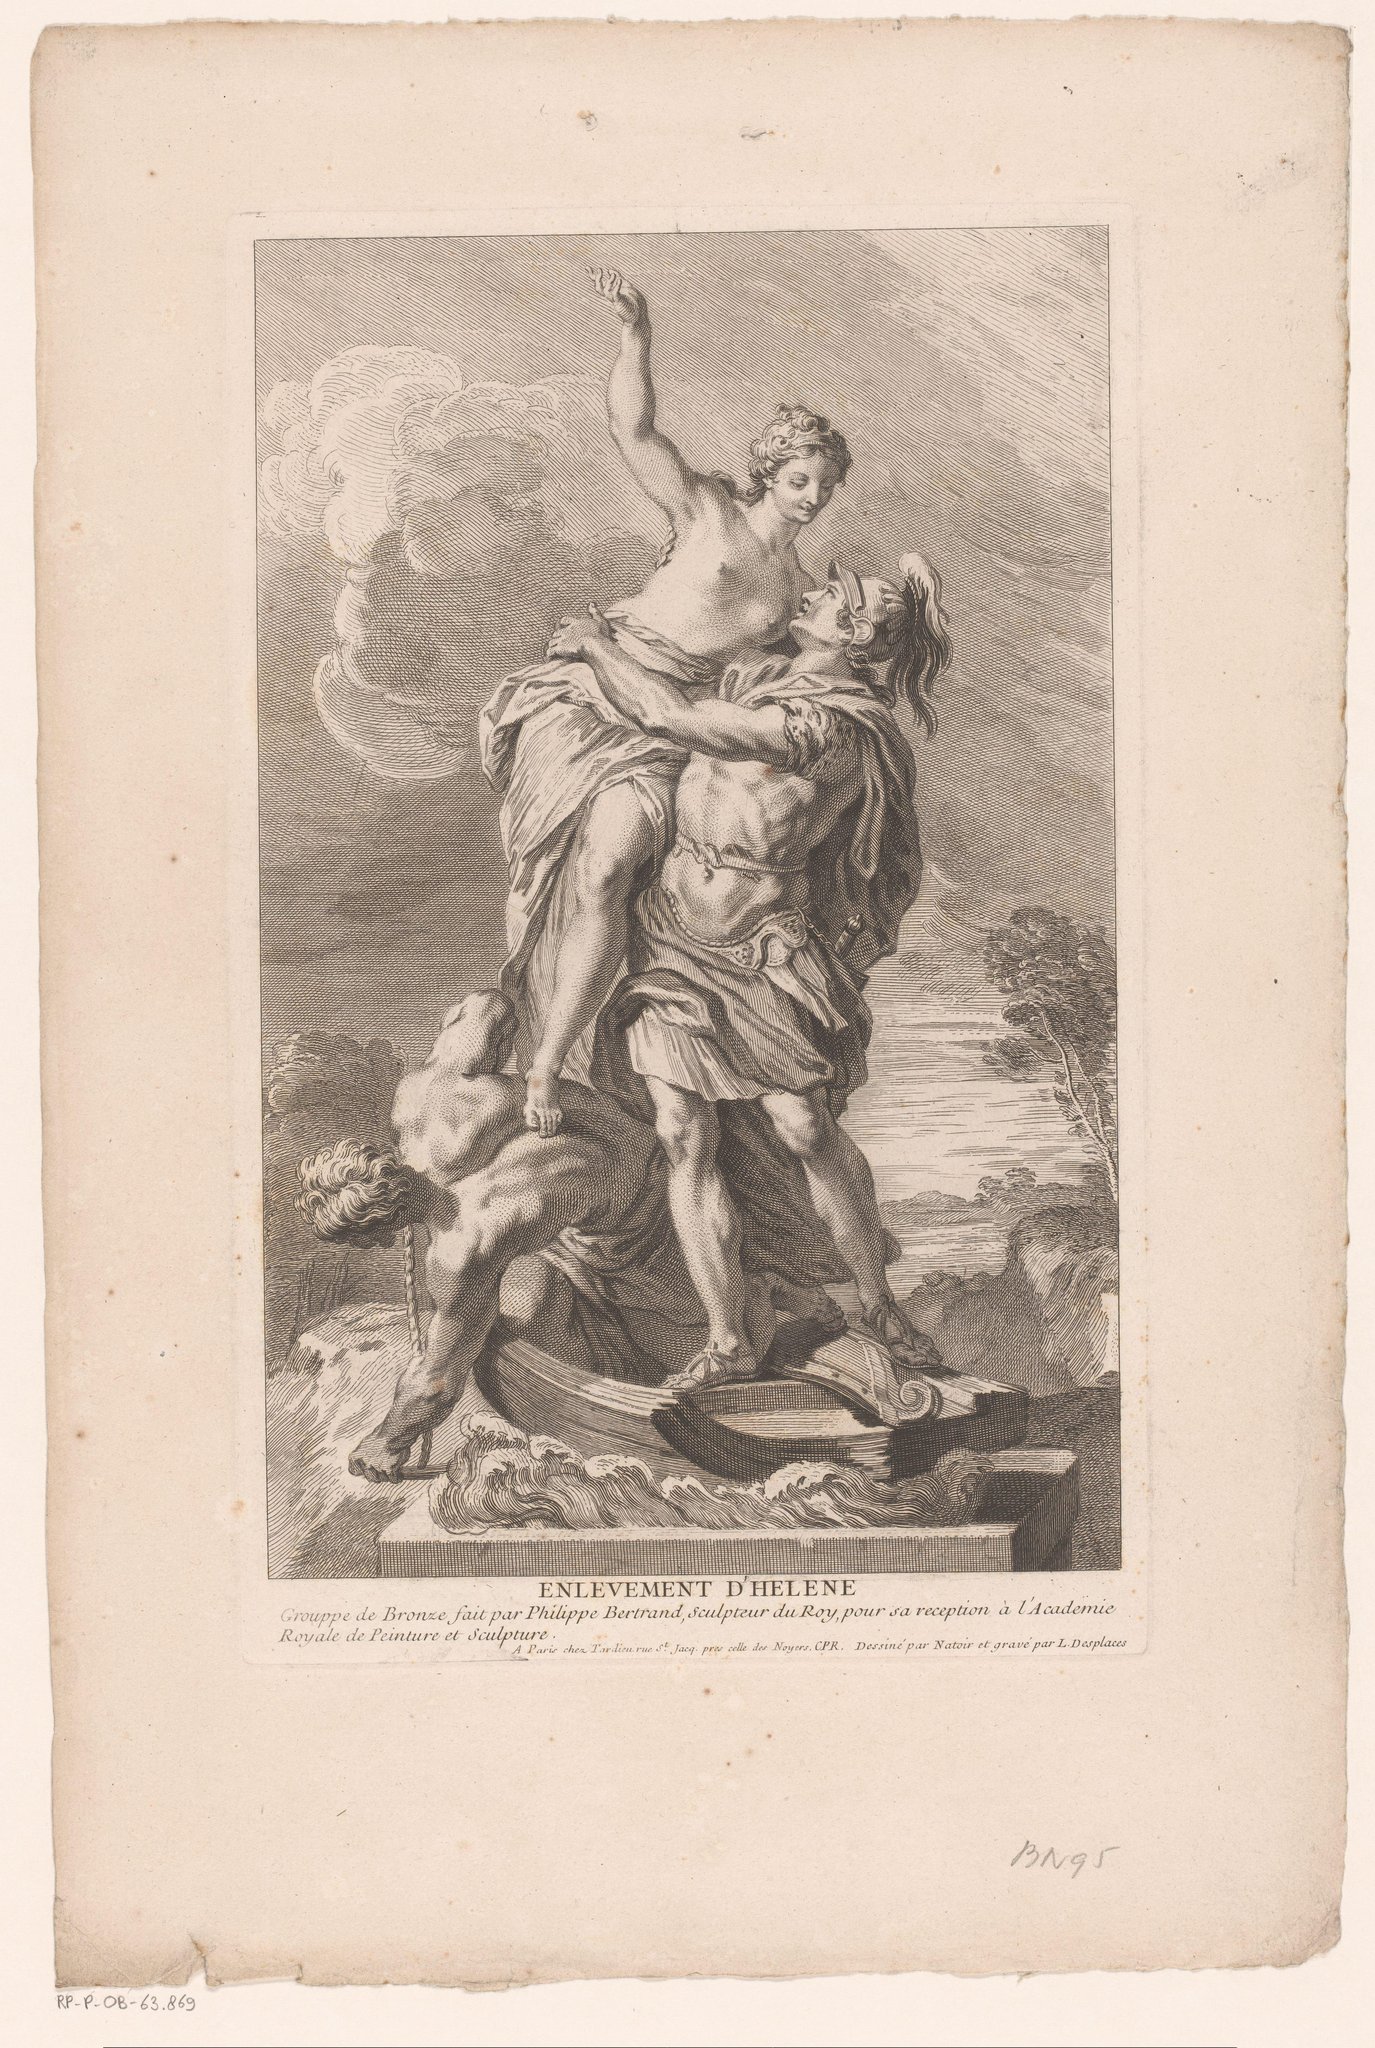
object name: print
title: Ontvoering van Helena door Paris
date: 1692-1739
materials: paper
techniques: engraving, etching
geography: paris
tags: the abduction of helen and some of her companions: paris carries them off by sea, and takes a part of the palace-treasure with him, piece of sculpture, reproduction of a piece of sculpture, (story of) helen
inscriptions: collector's mark: Lugt 2228